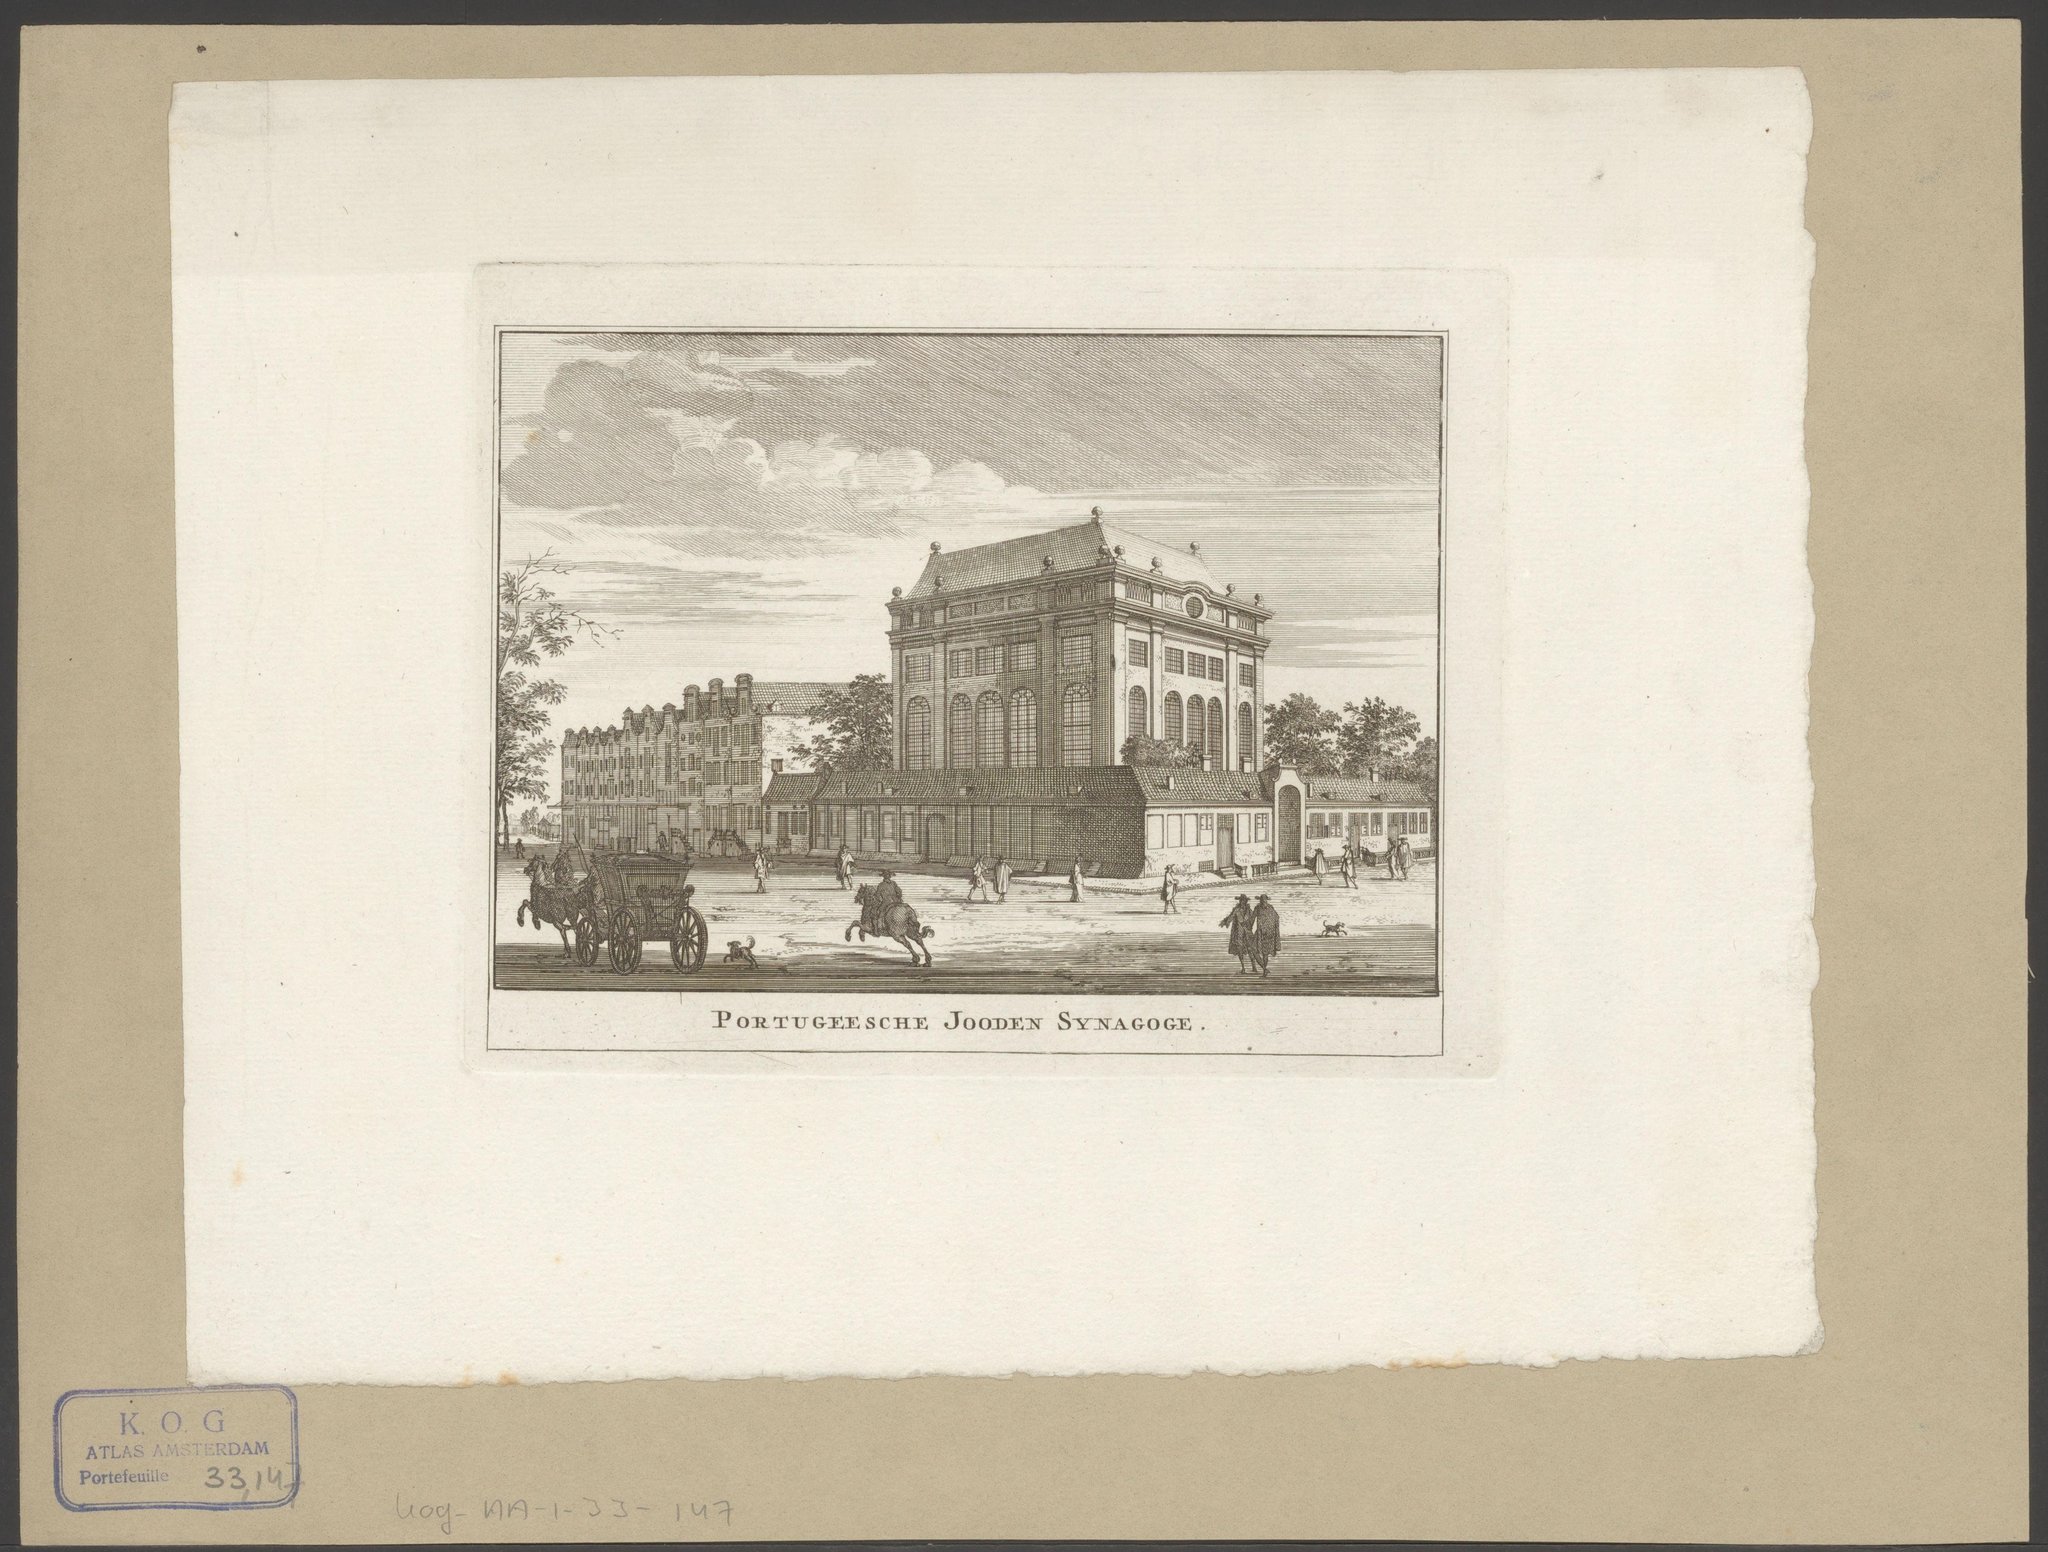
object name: print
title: Portugeesche Jooden Synagoge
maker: Anonymous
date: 1751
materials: paper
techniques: engraving, etching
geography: northern netherlands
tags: the synagogue (as building and place of worship ~ jewish religion), street (+ city(-scape) with figures, staffage)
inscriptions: collector's mark: Lugt 1641b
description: Eerste staat van prent, genummerd 202, gebruikt in: Hoorn, Nicolaas ten. Wegwyzer door Amsterdam zynde eene beknopte verhandeling van desselfs eerste opkomst, vergrootingen, en teegenwoordigen staat (...). Amsterdam: Nicolaas ten Hoorn, 1713. En in: Hoorn, Nicolaas ten. Wegwyzer door Amsterdam zynde eene beknopte verhandeling van desselfs eerste opkomst, vergrootingen, en teegenwoordigen staat (...). Amsterdam: Nicolaas ten Hoorn, 1726. Tweede staat van prent, genummerd 214, gebruikt in: Hoorn, Nicolaas ten. Wegwyzer door Amsterdam zynde eene beknopte verhandeling van desselfs eerste opkomst, vergrootingen, en teegenwoordigen staat (...). Amsterdam: Nicolaas ten Hoorn, 1726. En in: Hoorn, Nicolaas ten. Wegwyzer, of korte beschryvinge van de stadt Amsterdam, zynde eene beknopte verhandeling van desselfs eerste opkomst, vergrootingen, en teegenwoordigen staat (...). Amsterdam: erven J. Ratelband & Co, 1737. En in: Hoorn, Nicolaas ten. Wegwyzer of korte beschryvinge der stad Amsterdam, zynde eene beknopte verhandeling van derzelver eerste opkomst, vergrootingen, en tegenwoordigen staat (...). Amsterdam: Pieter Meyer, 1751.